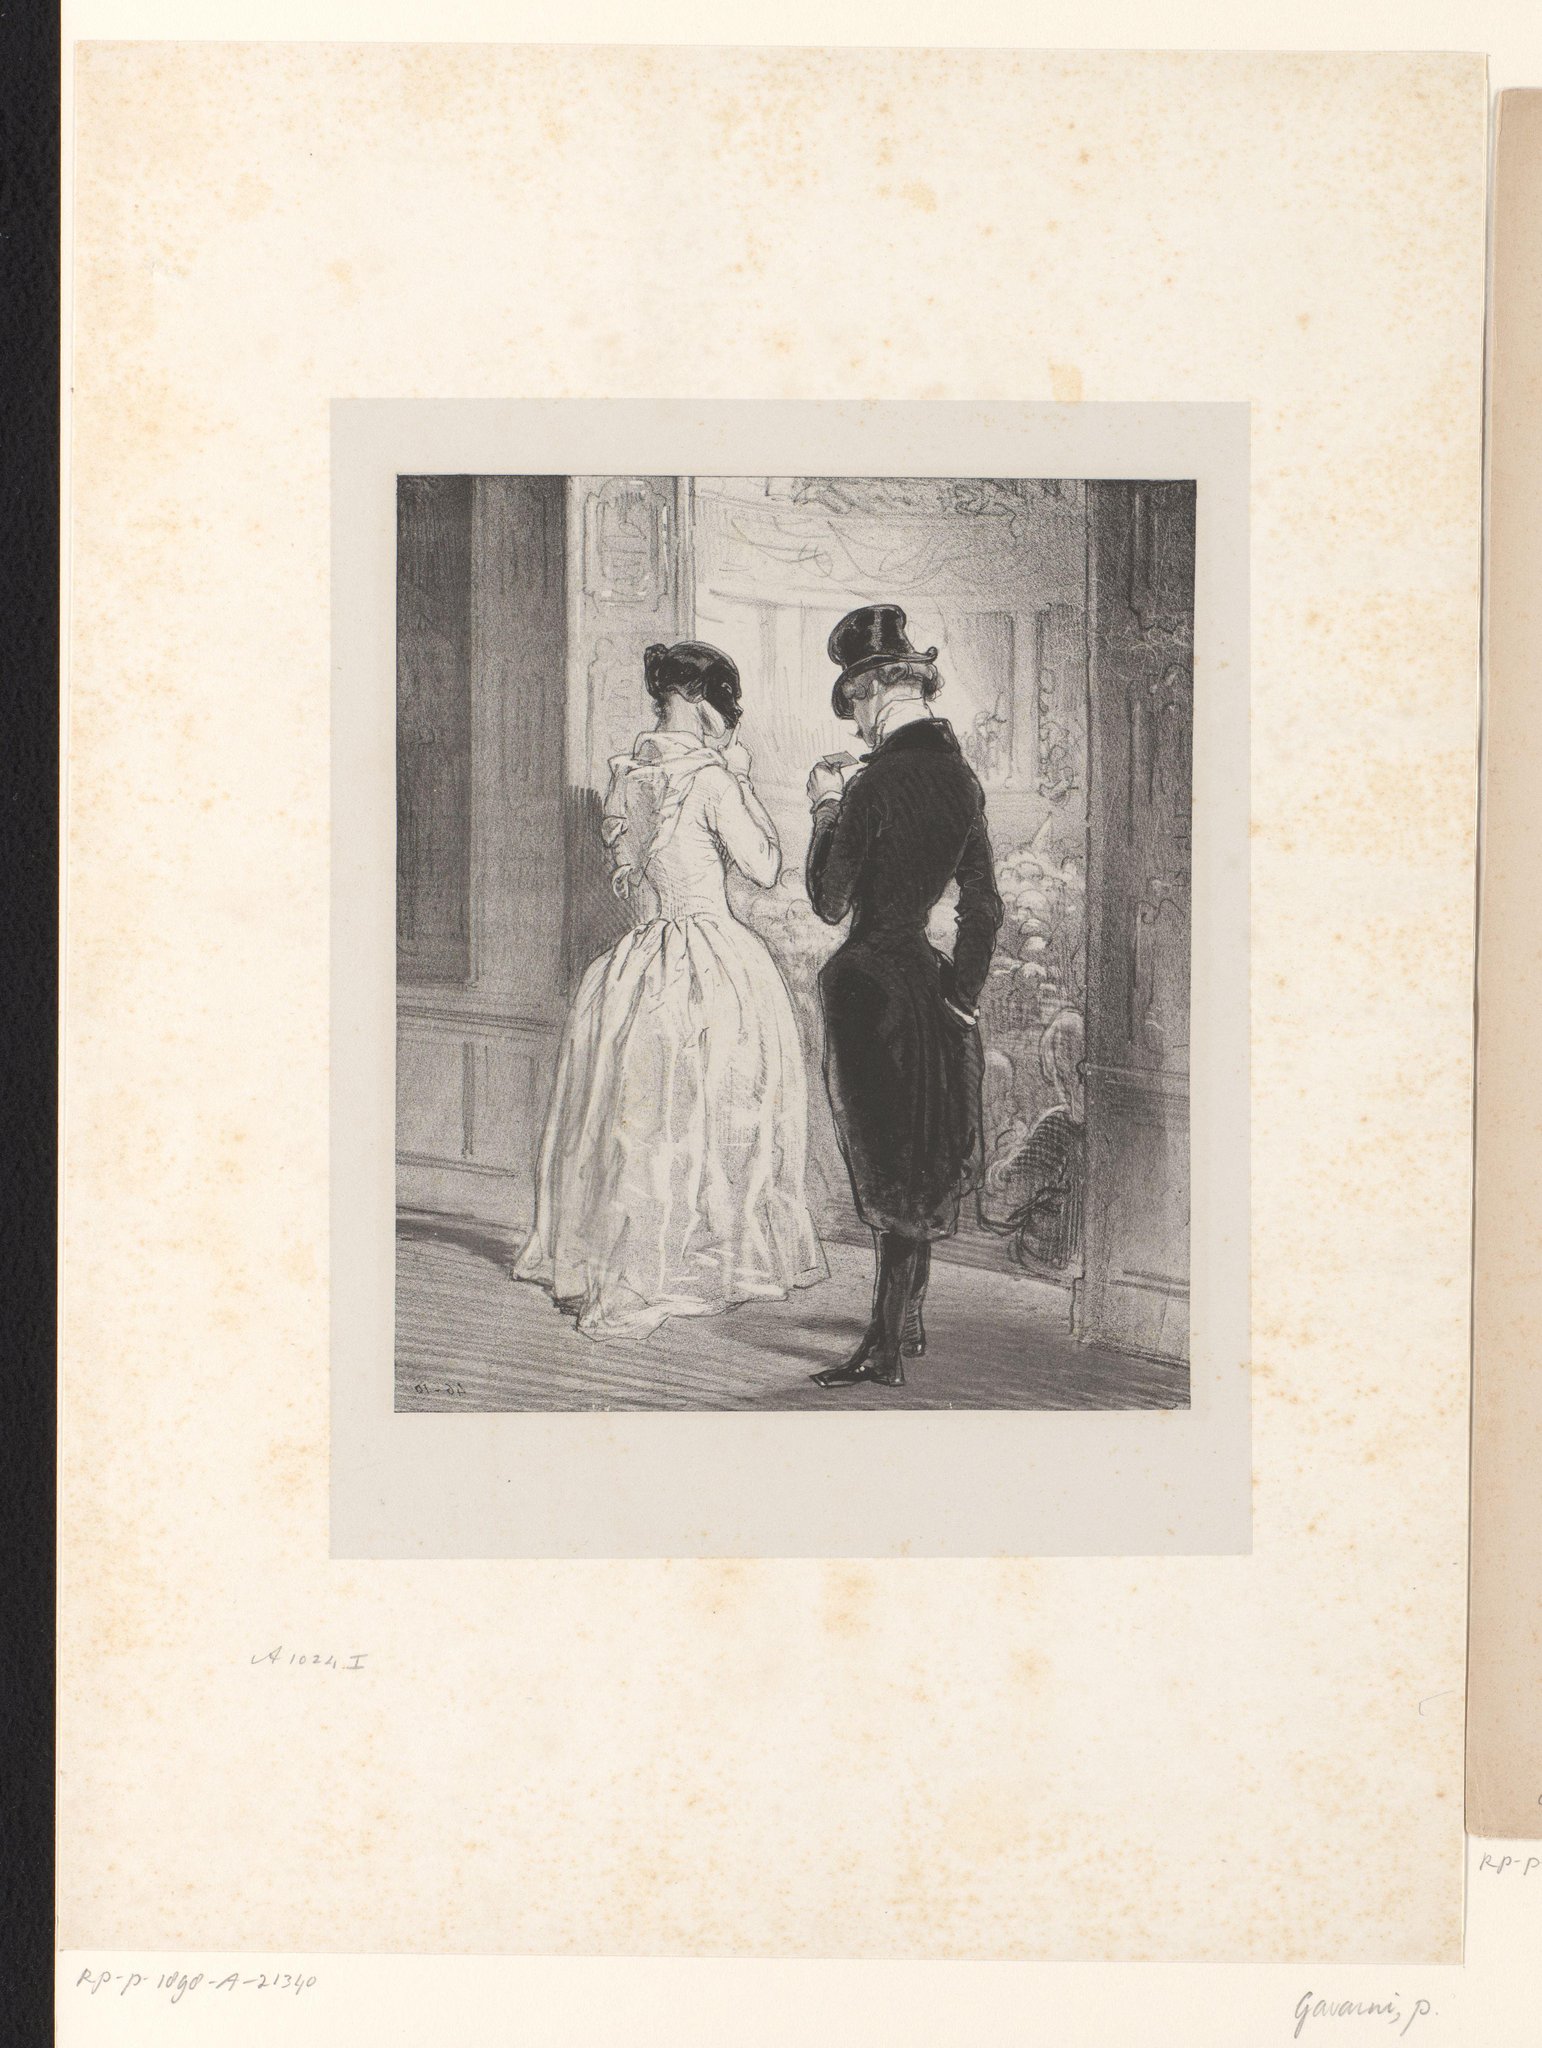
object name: cartoon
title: Oeuvres nouvelles de Gavarni. Carnaval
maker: paul gavarni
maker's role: draughtsman, print maker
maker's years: 1804-1866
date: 1846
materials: paper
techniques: lithograph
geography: paris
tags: mask, reading, masquerade, masked ball, carnival, shrovetide (non-liturgical celebration)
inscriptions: collector's mark: Lugt 964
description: De man leest een kaart die de vrouw hem zojuist gegeven heeft. Zij gebaart dat hij over de inhoud moet zwijgen.